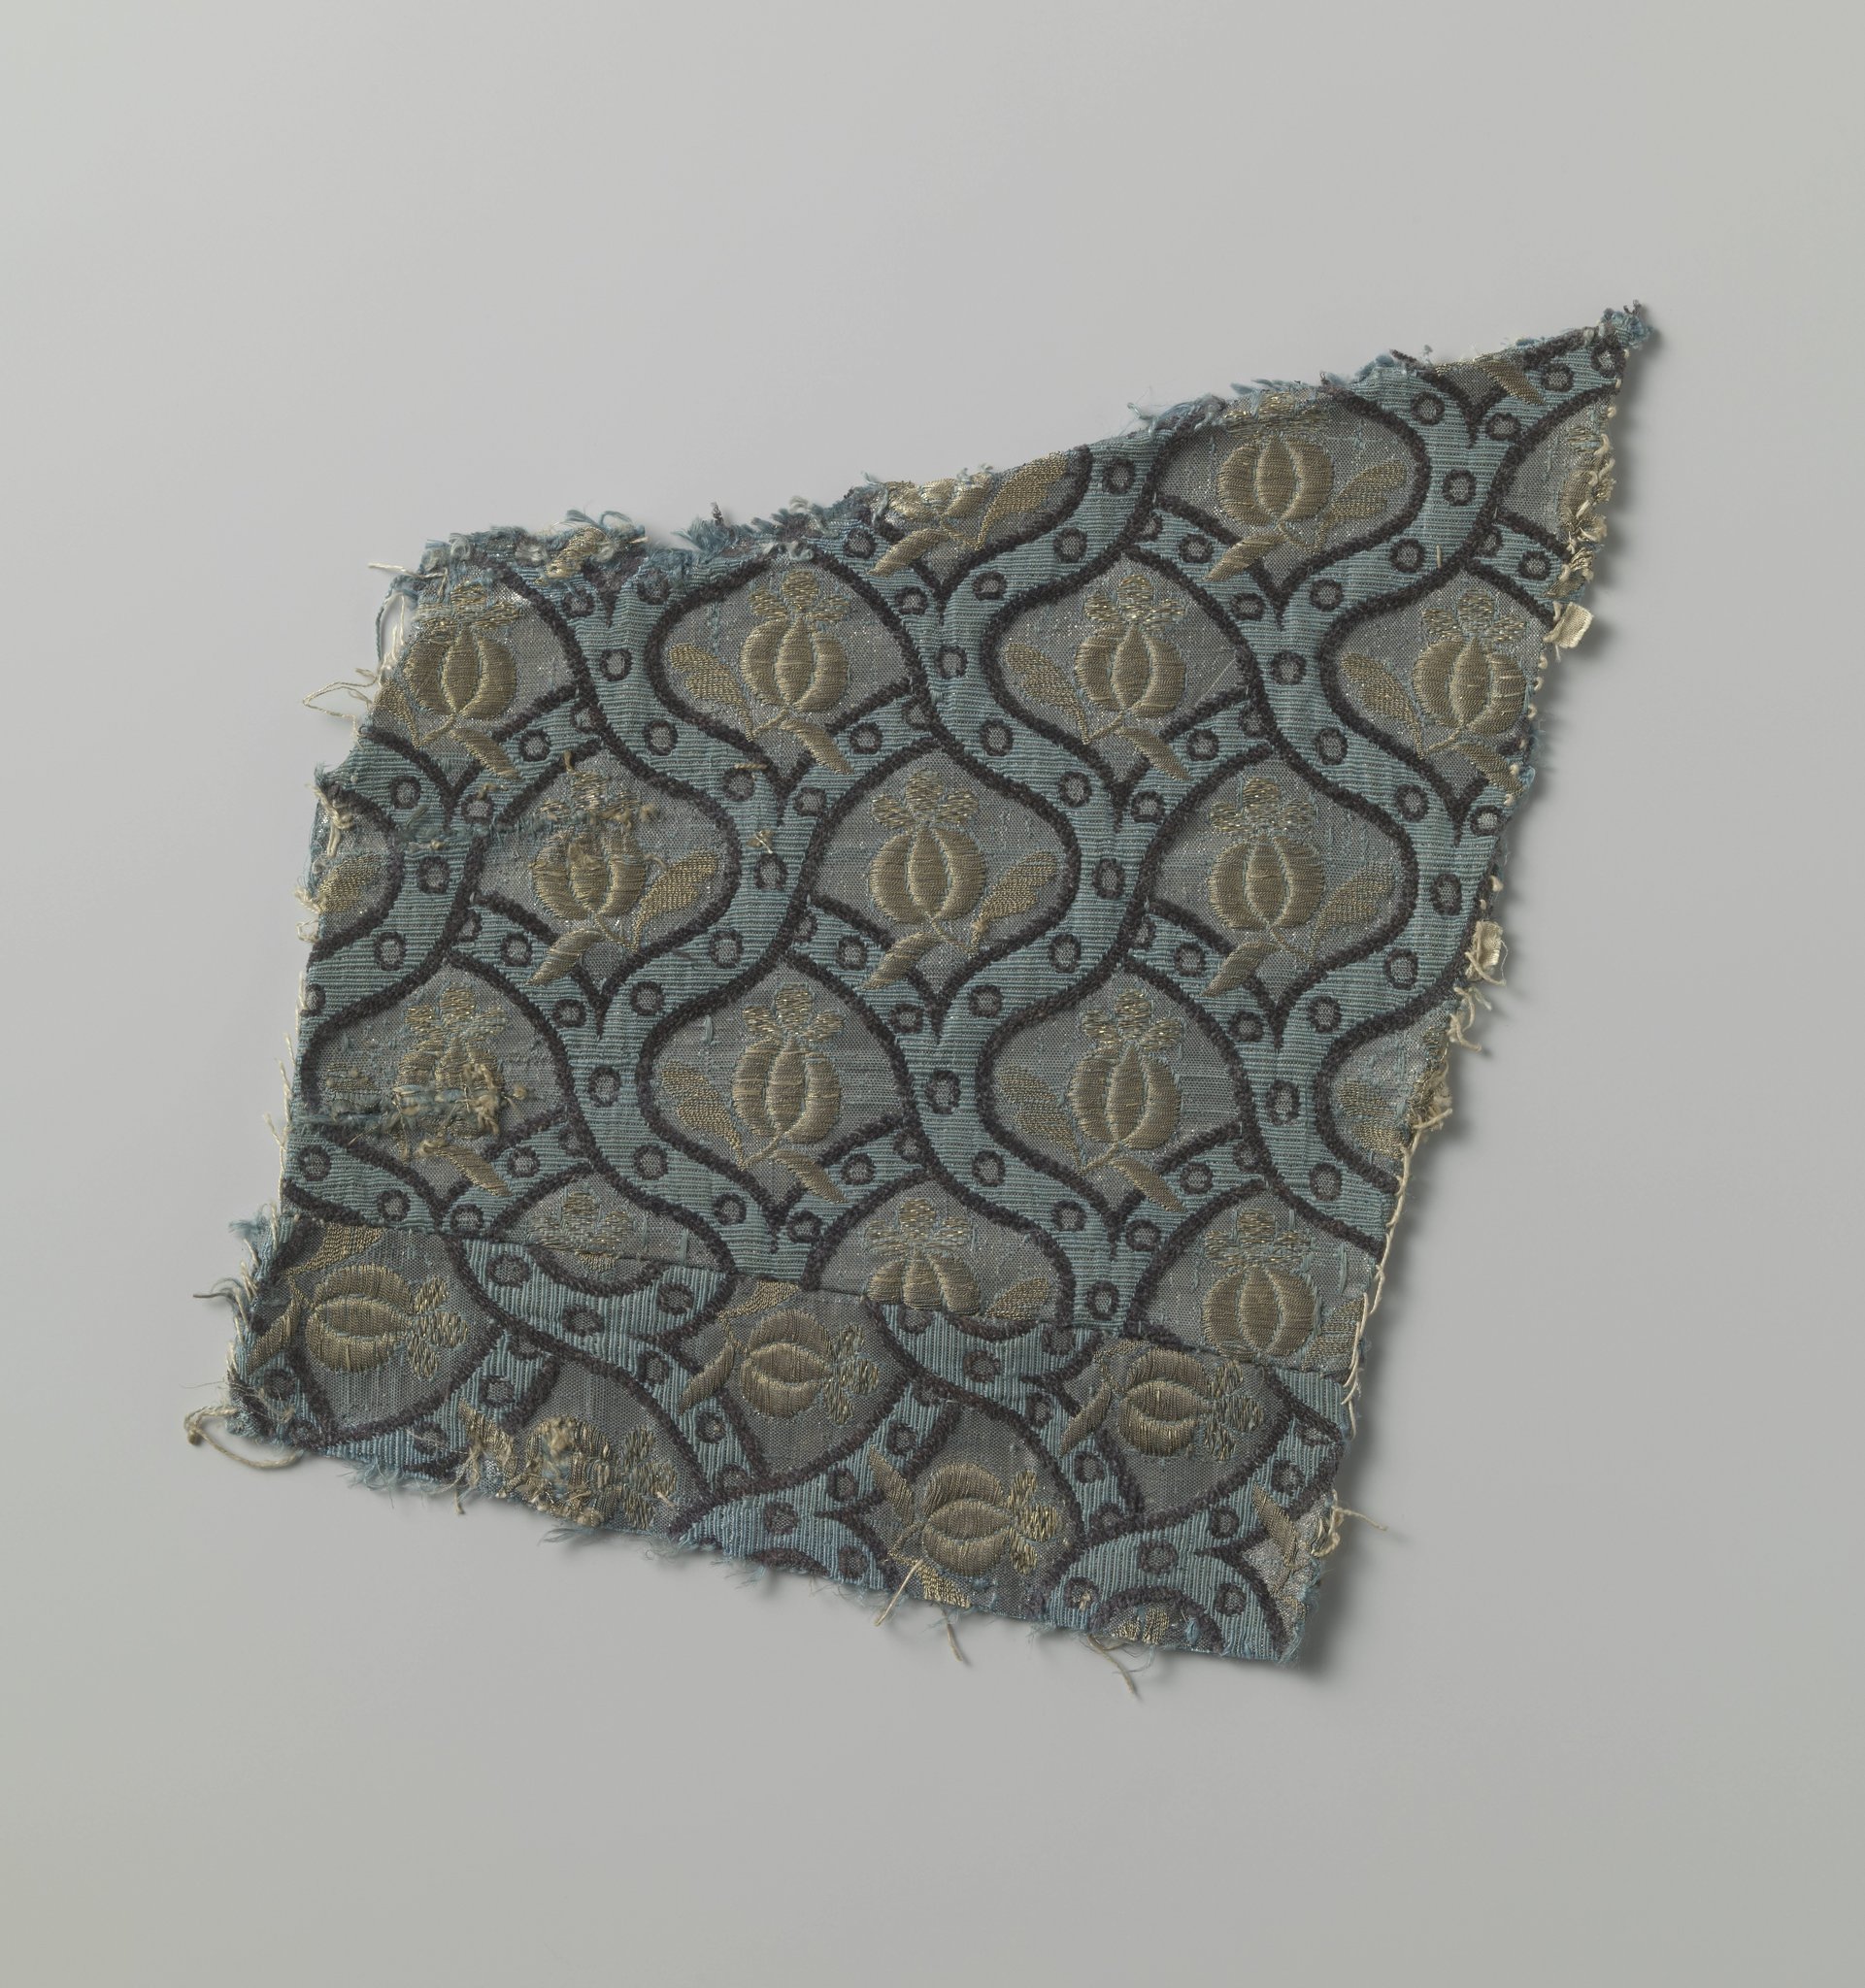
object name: fragment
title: Fragment droguet met vlechtbandmotieven en granaatappels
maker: Anonymous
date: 1725-1799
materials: textile, metal thread, silk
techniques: brocade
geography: france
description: Fragment van 2 aan elkaar gezette stukken (niet op patroon) zijden droguet met slingerbandversiering met in de ontstane openingen granaatappels.